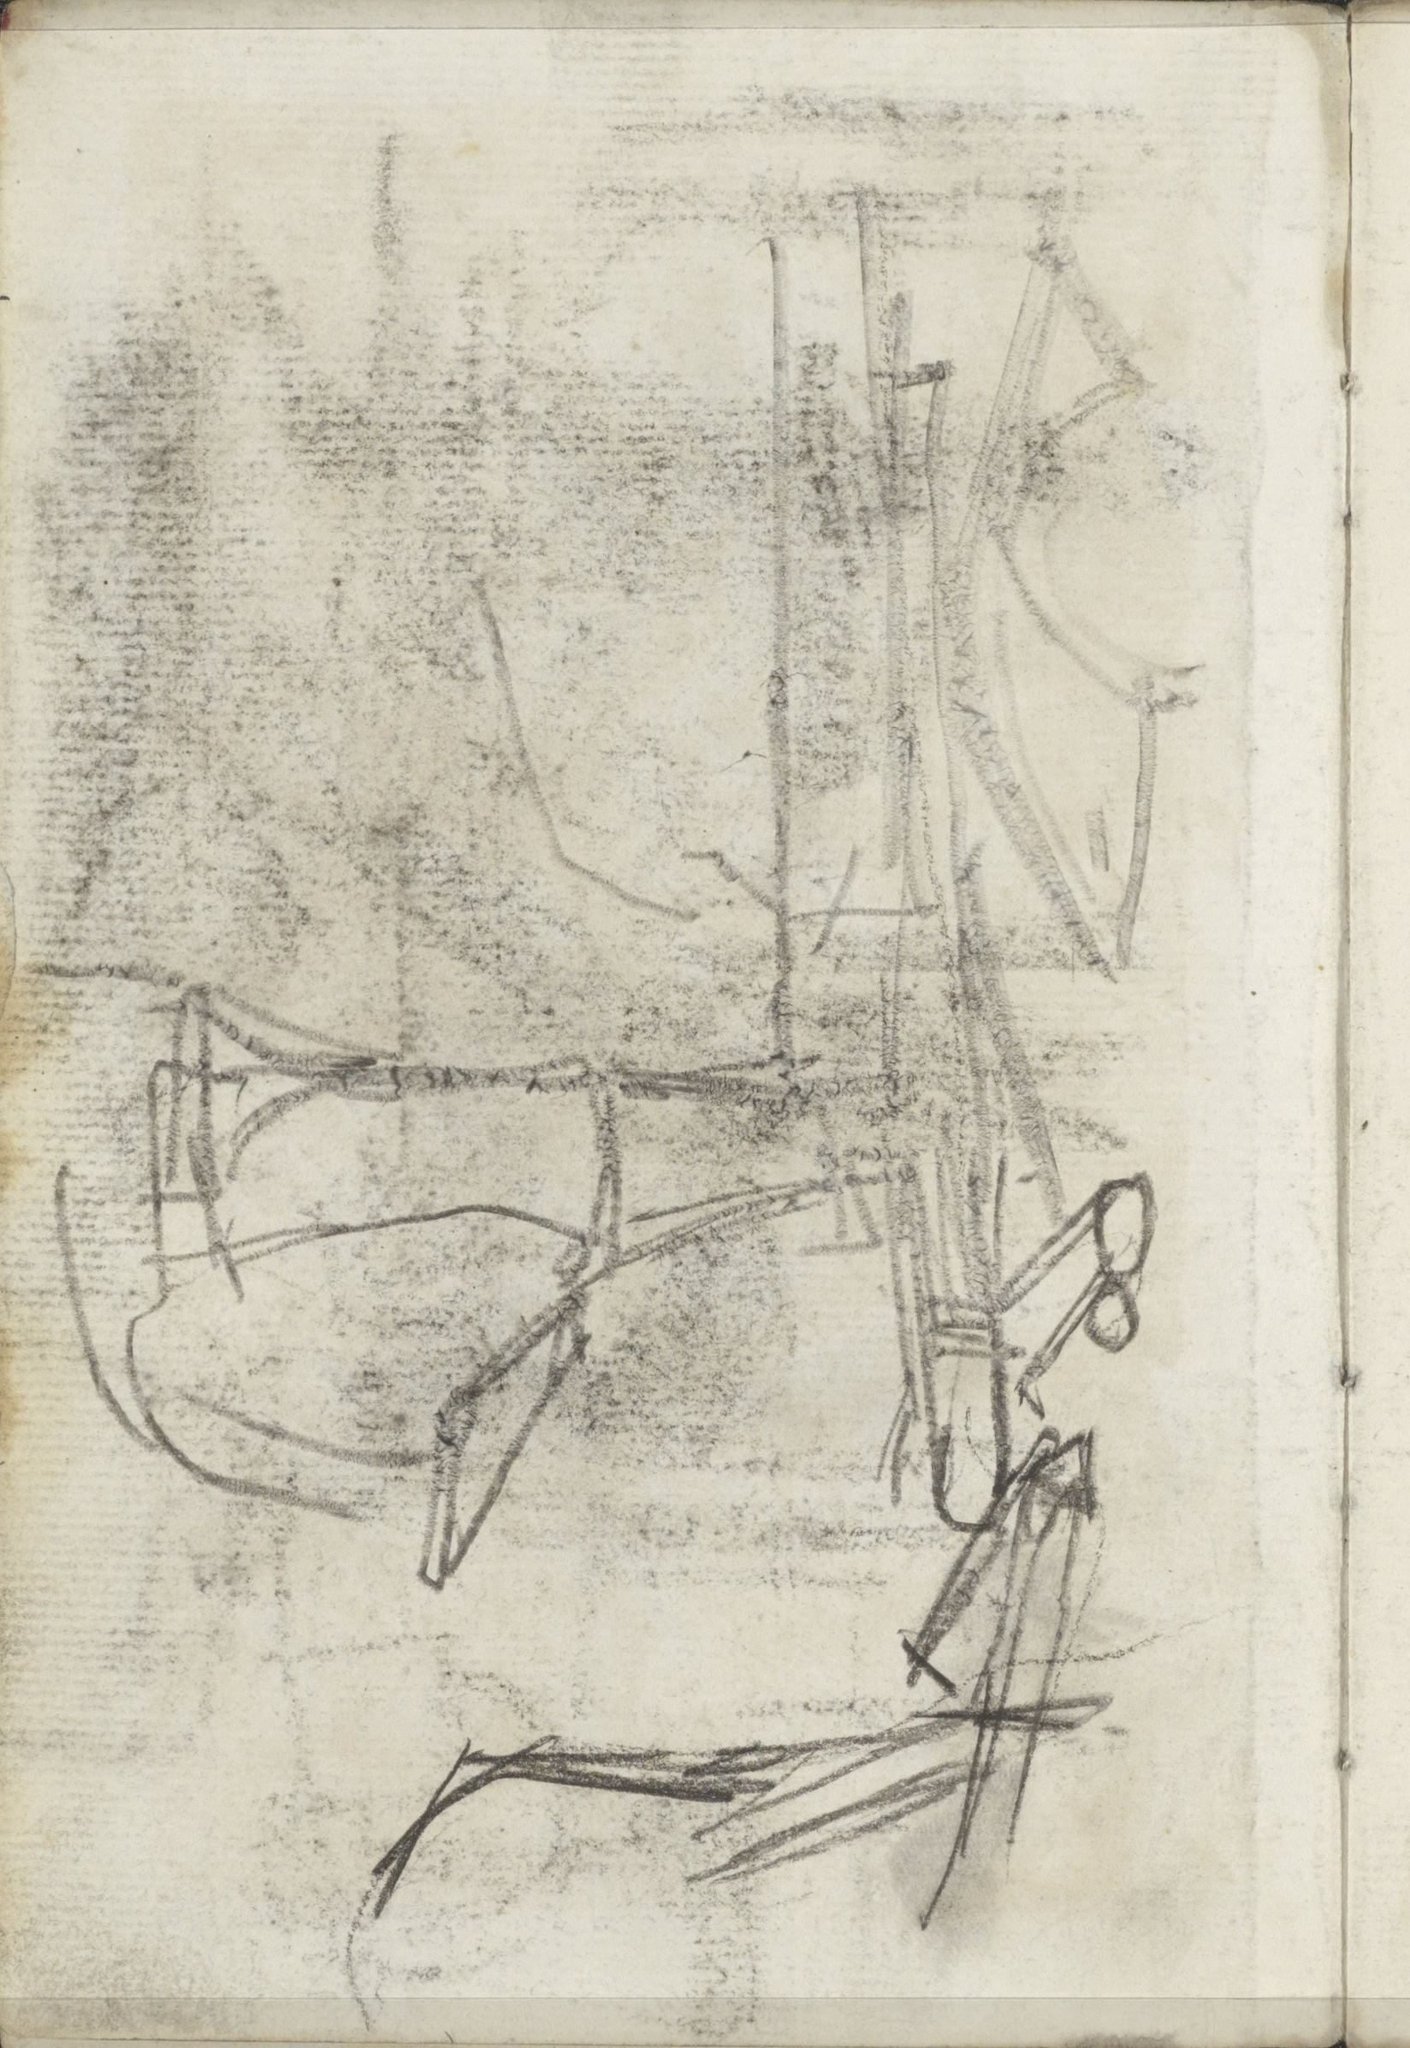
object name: sketchbook leaf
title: Figuurstudie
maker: george hendrik breitner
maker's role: draughtsman, painter, print maker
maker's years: 1857-1923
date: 1886-1898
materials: chalk, paper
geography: amsterdam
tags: adult man (+ back view)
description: Pagina 3 uit een schetsboek met 21 bladen.